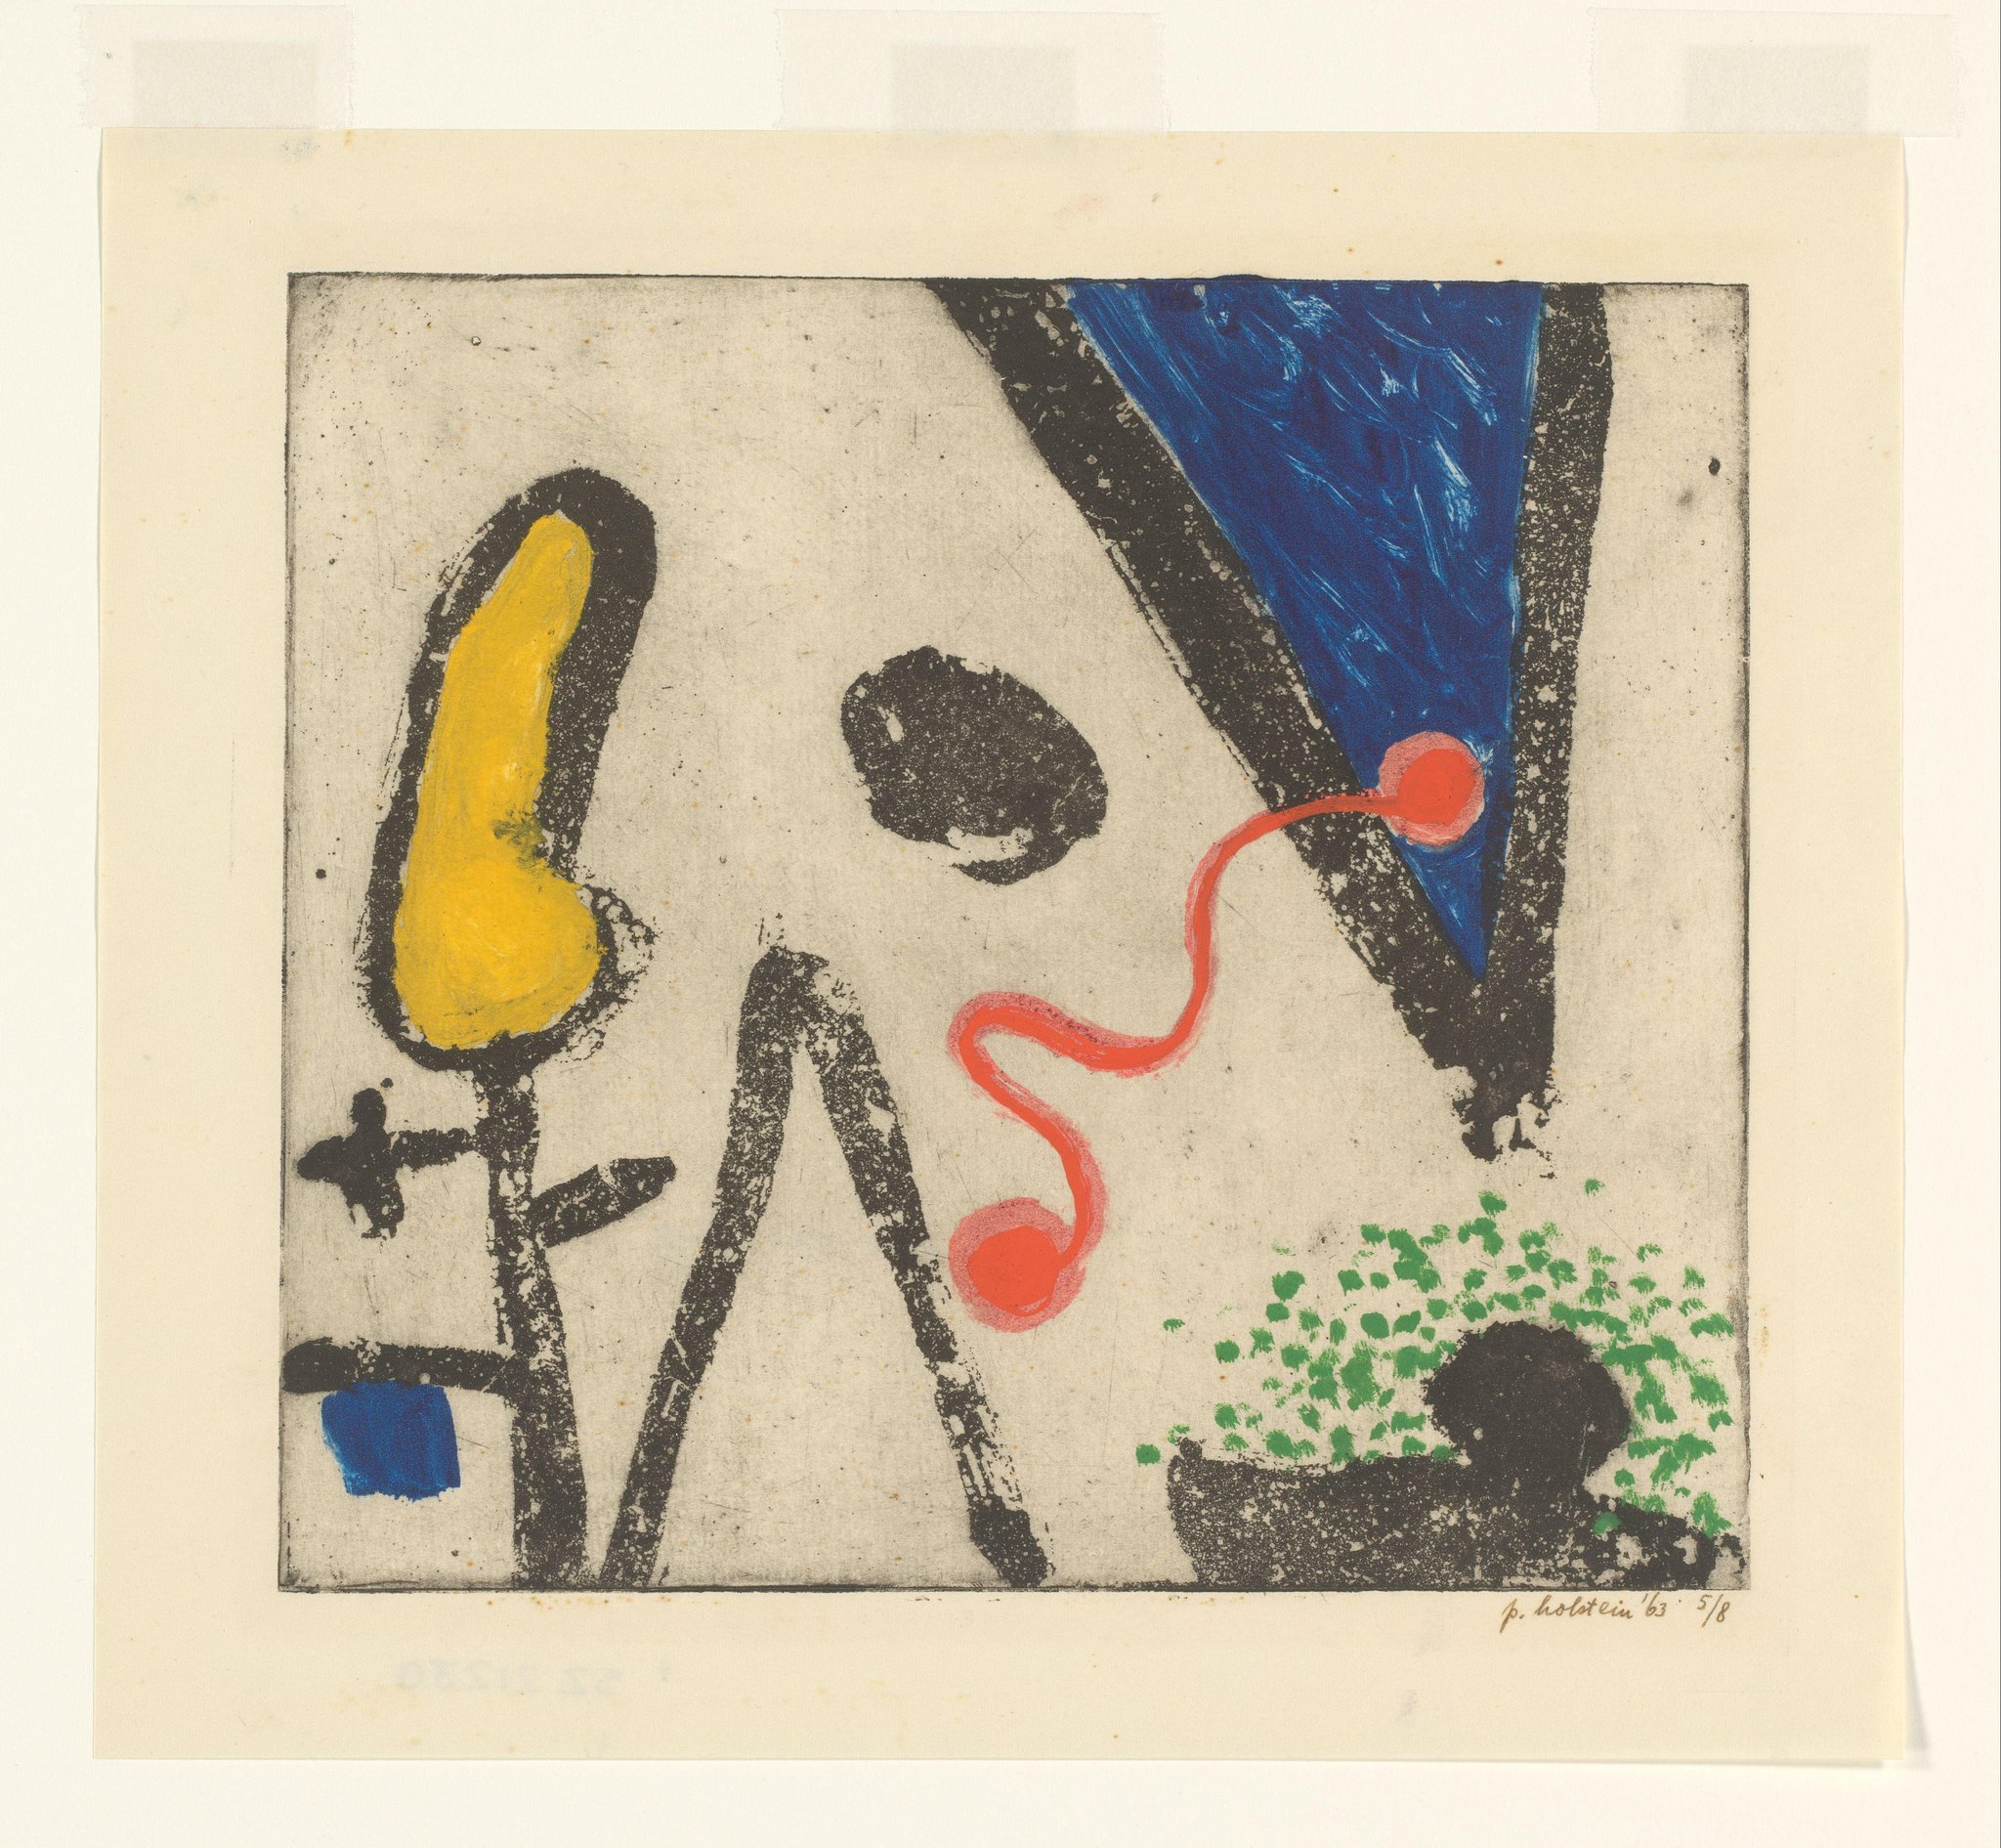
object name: print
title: Landschap III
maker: pieter holstein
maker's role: draughtsman, painter, print maker, sculptor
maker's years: 1934-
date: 1963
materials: gouache, paper, ink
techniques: aquatint, brush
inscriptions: signature, date and inscription: ‘p. holstein '63 5/8’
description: Compositie in zwart, groen, blauw, rood en geel. Rechtsboven een punt in blauw met zwarte contouren.